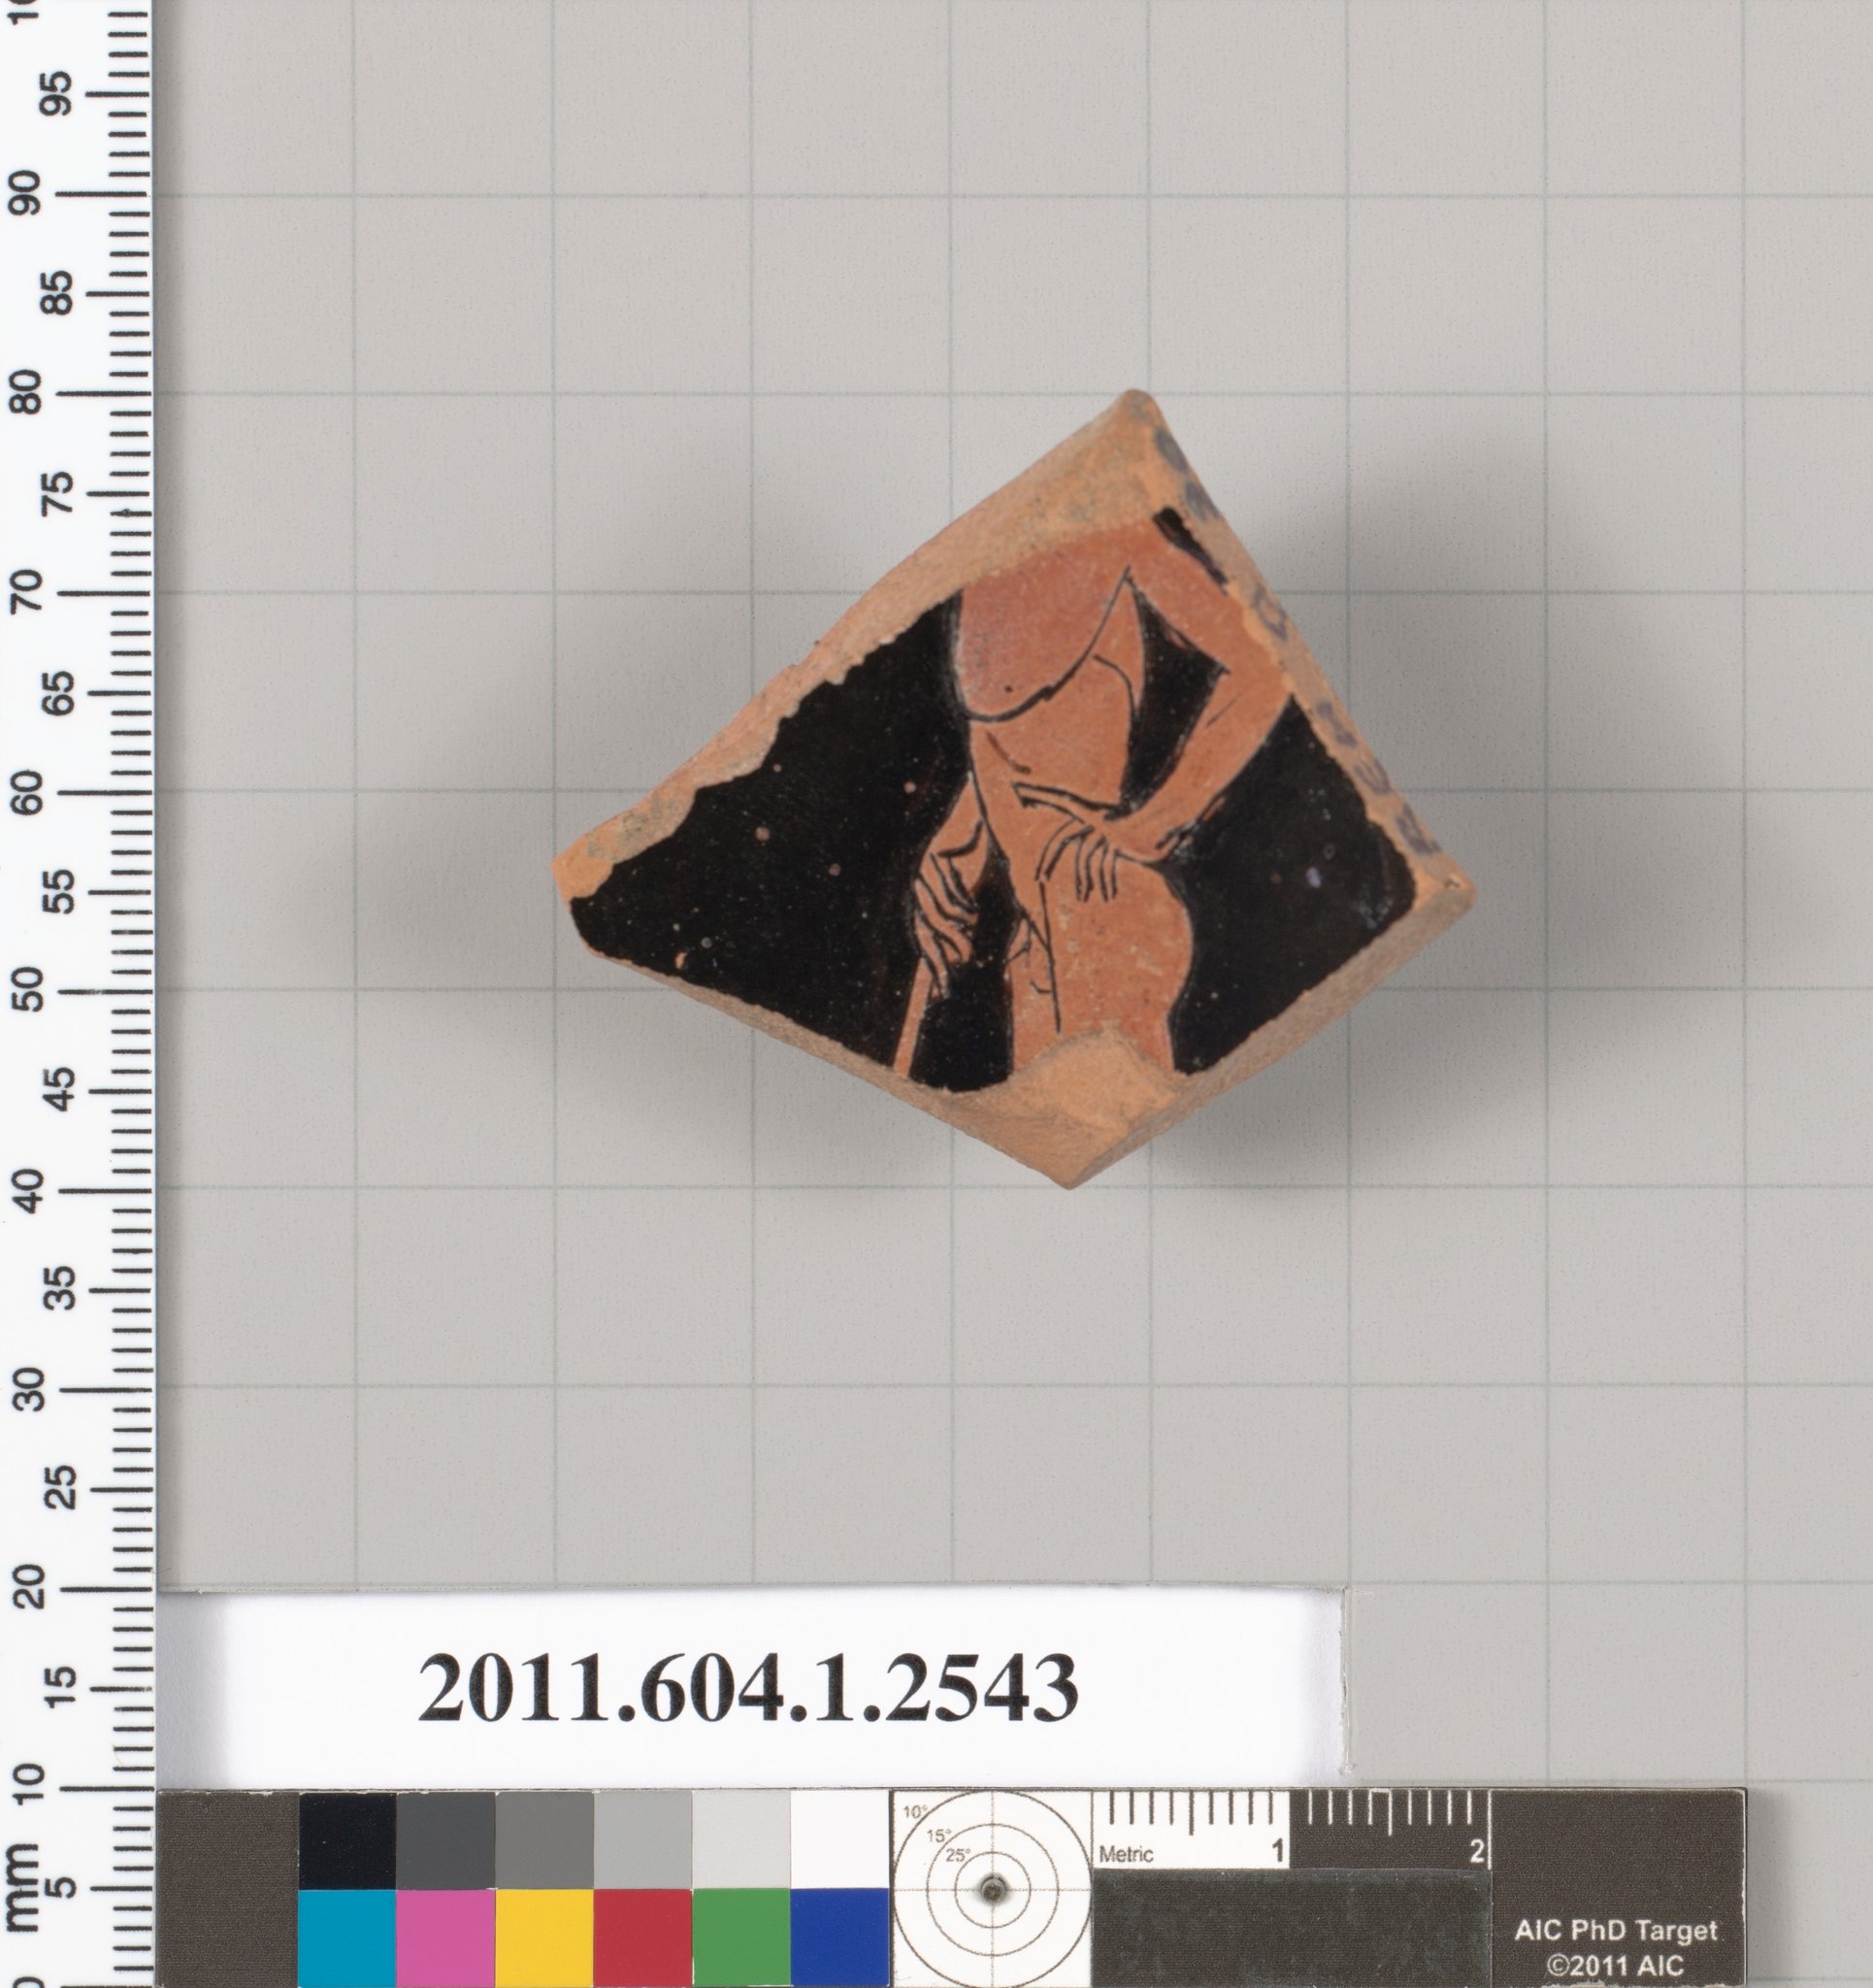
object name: kylix fragment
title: Terracotta fragment of a kylix (drinking cup)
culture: greek, attic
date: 490-480 BCE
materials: terracotta